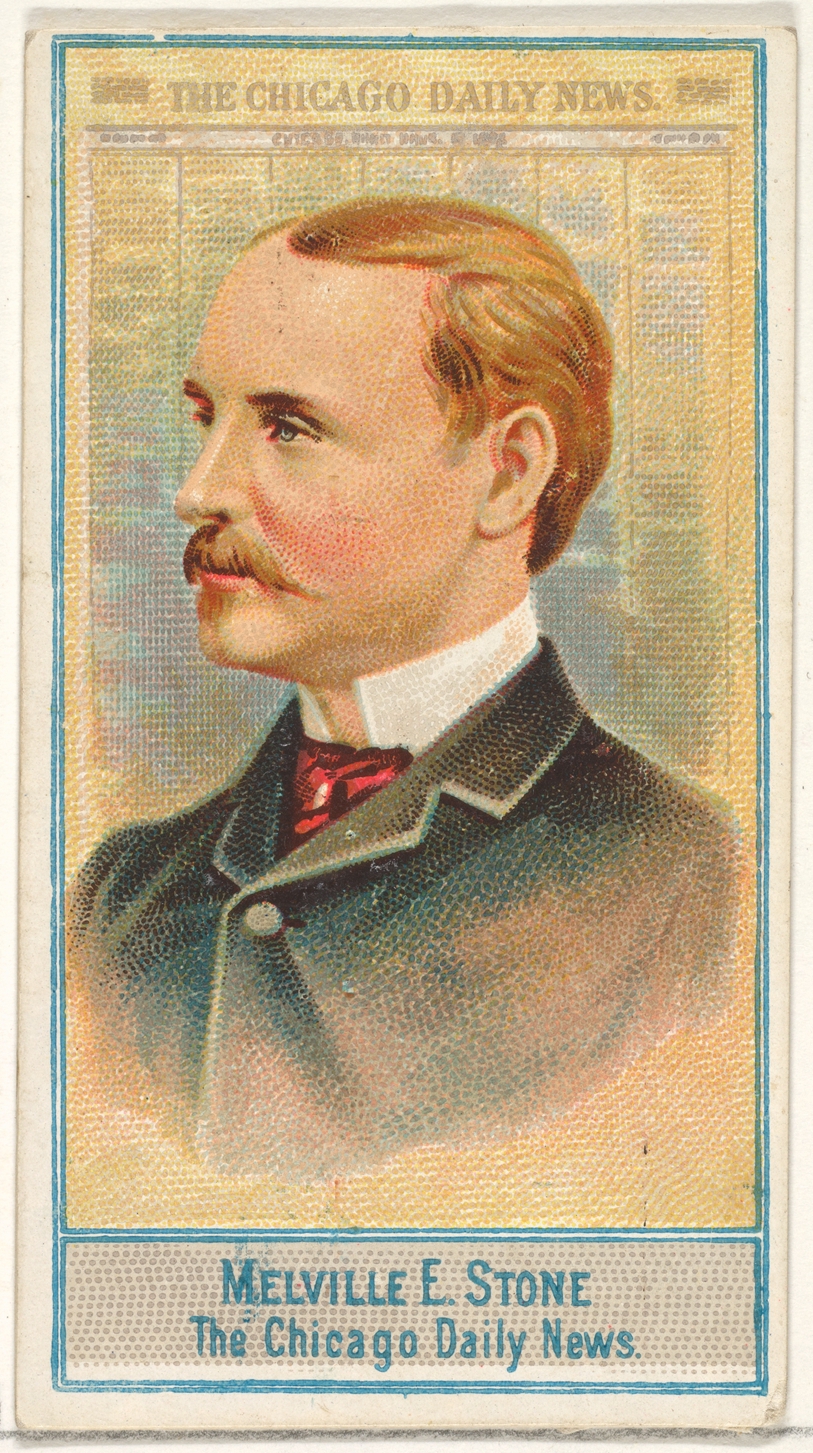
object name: print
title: Melville E. Stone, The Chicago Daily News, from the American Editors series (N1) for Allen & Ginter Cigarettes Brands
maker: allen & ginter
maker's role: publisher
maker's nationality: american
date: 1887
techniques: color lithograph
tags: men